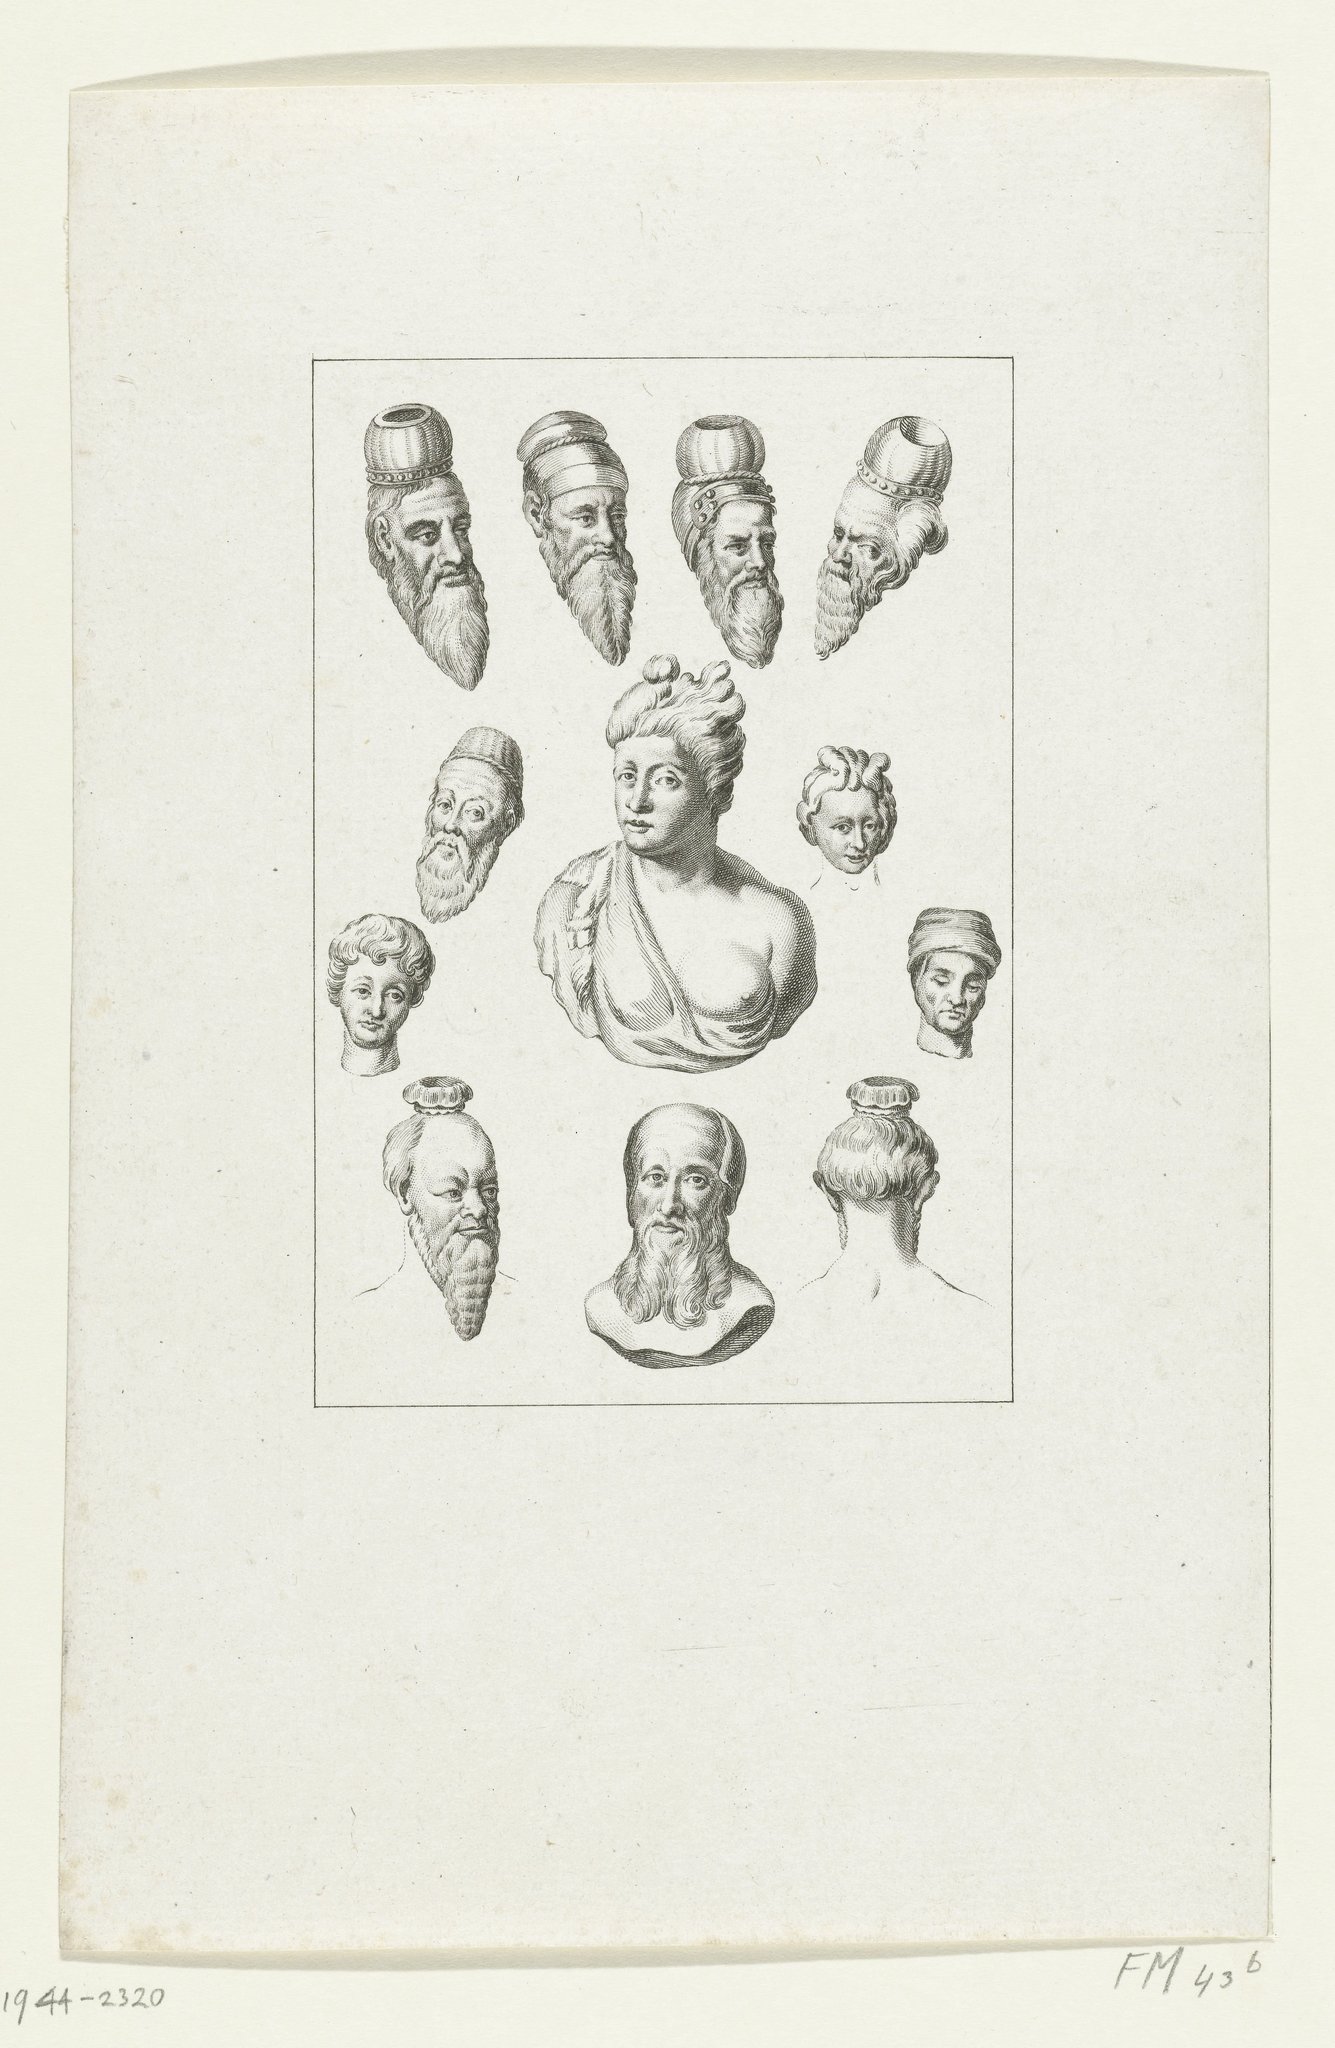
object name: historical object representation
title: Sicamber-kopjes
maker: reinier vinkeles (i)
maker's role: draughtsman, print maker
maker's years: 1741-1816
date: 1782-1784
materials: paper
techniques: etching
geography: netherlands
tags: extinct, 'historical' peoples (with name)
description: Illustratie uit: E.M. Engelberts, De aloude staat en geschiedenissen der Vereenigde Nederlanden, Johannes Allart, Amsterdam 1784-1799, dl. I, p. 340. Staat vóór de letter.